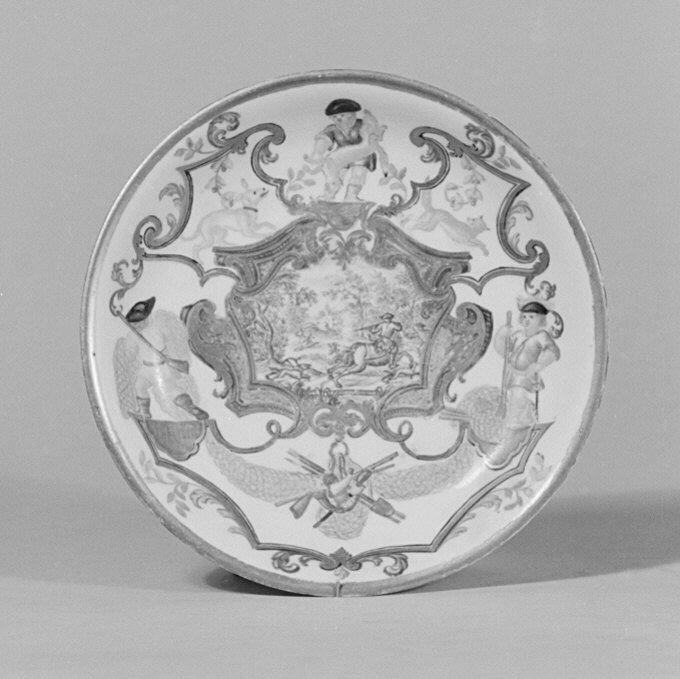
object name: saucer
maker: vienna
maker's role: manufactory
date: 1725-1730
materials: hard paste porcelain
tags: horses,coat of arms